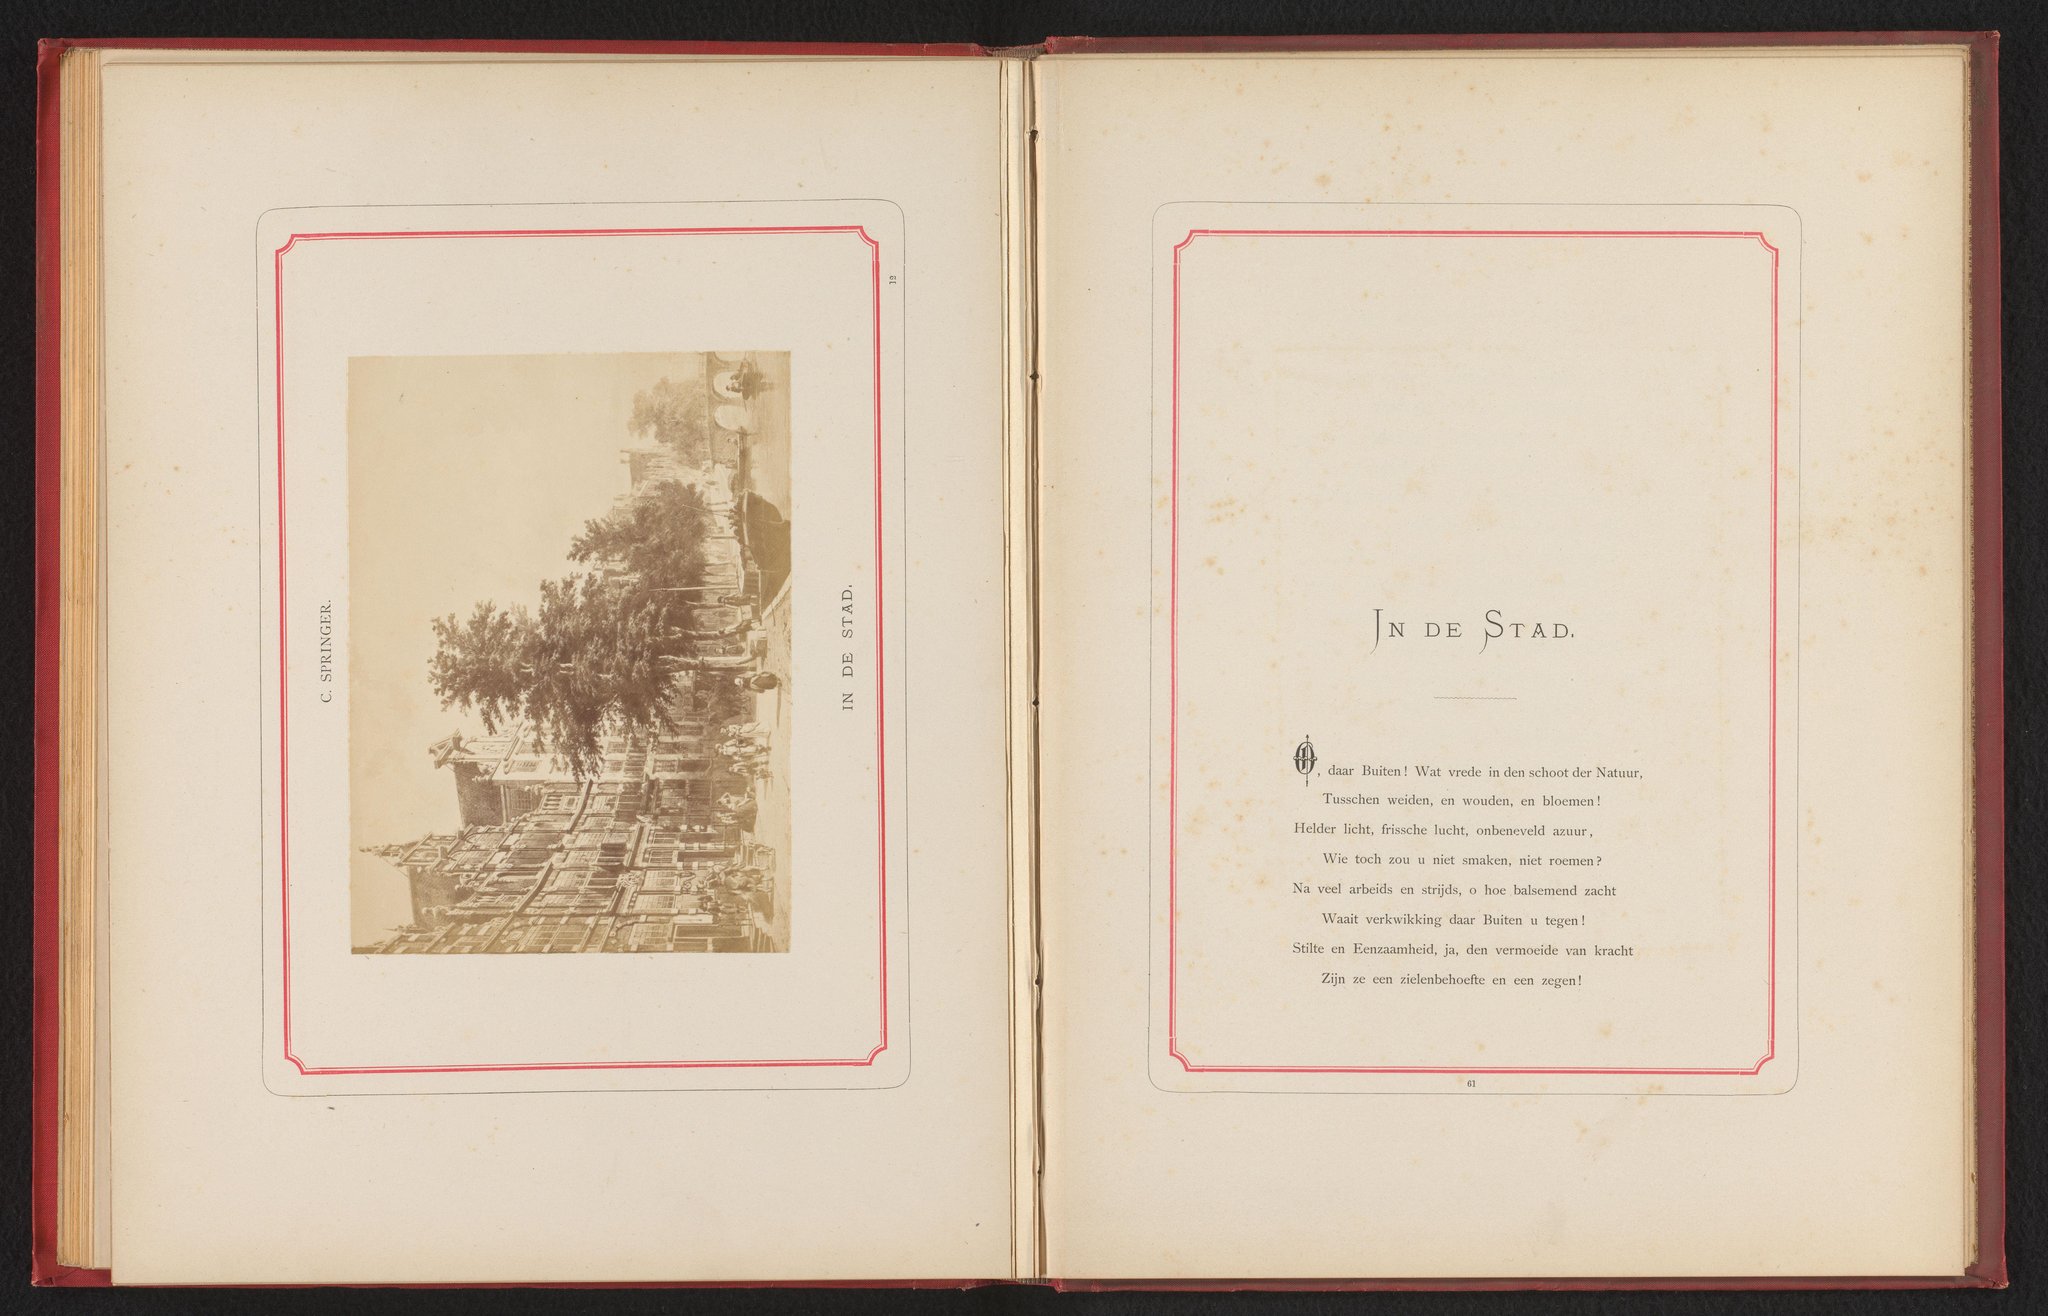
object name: page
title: In de stad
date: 1865-1878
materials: paper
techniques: albumen print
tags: city-view in general; 'veduta'